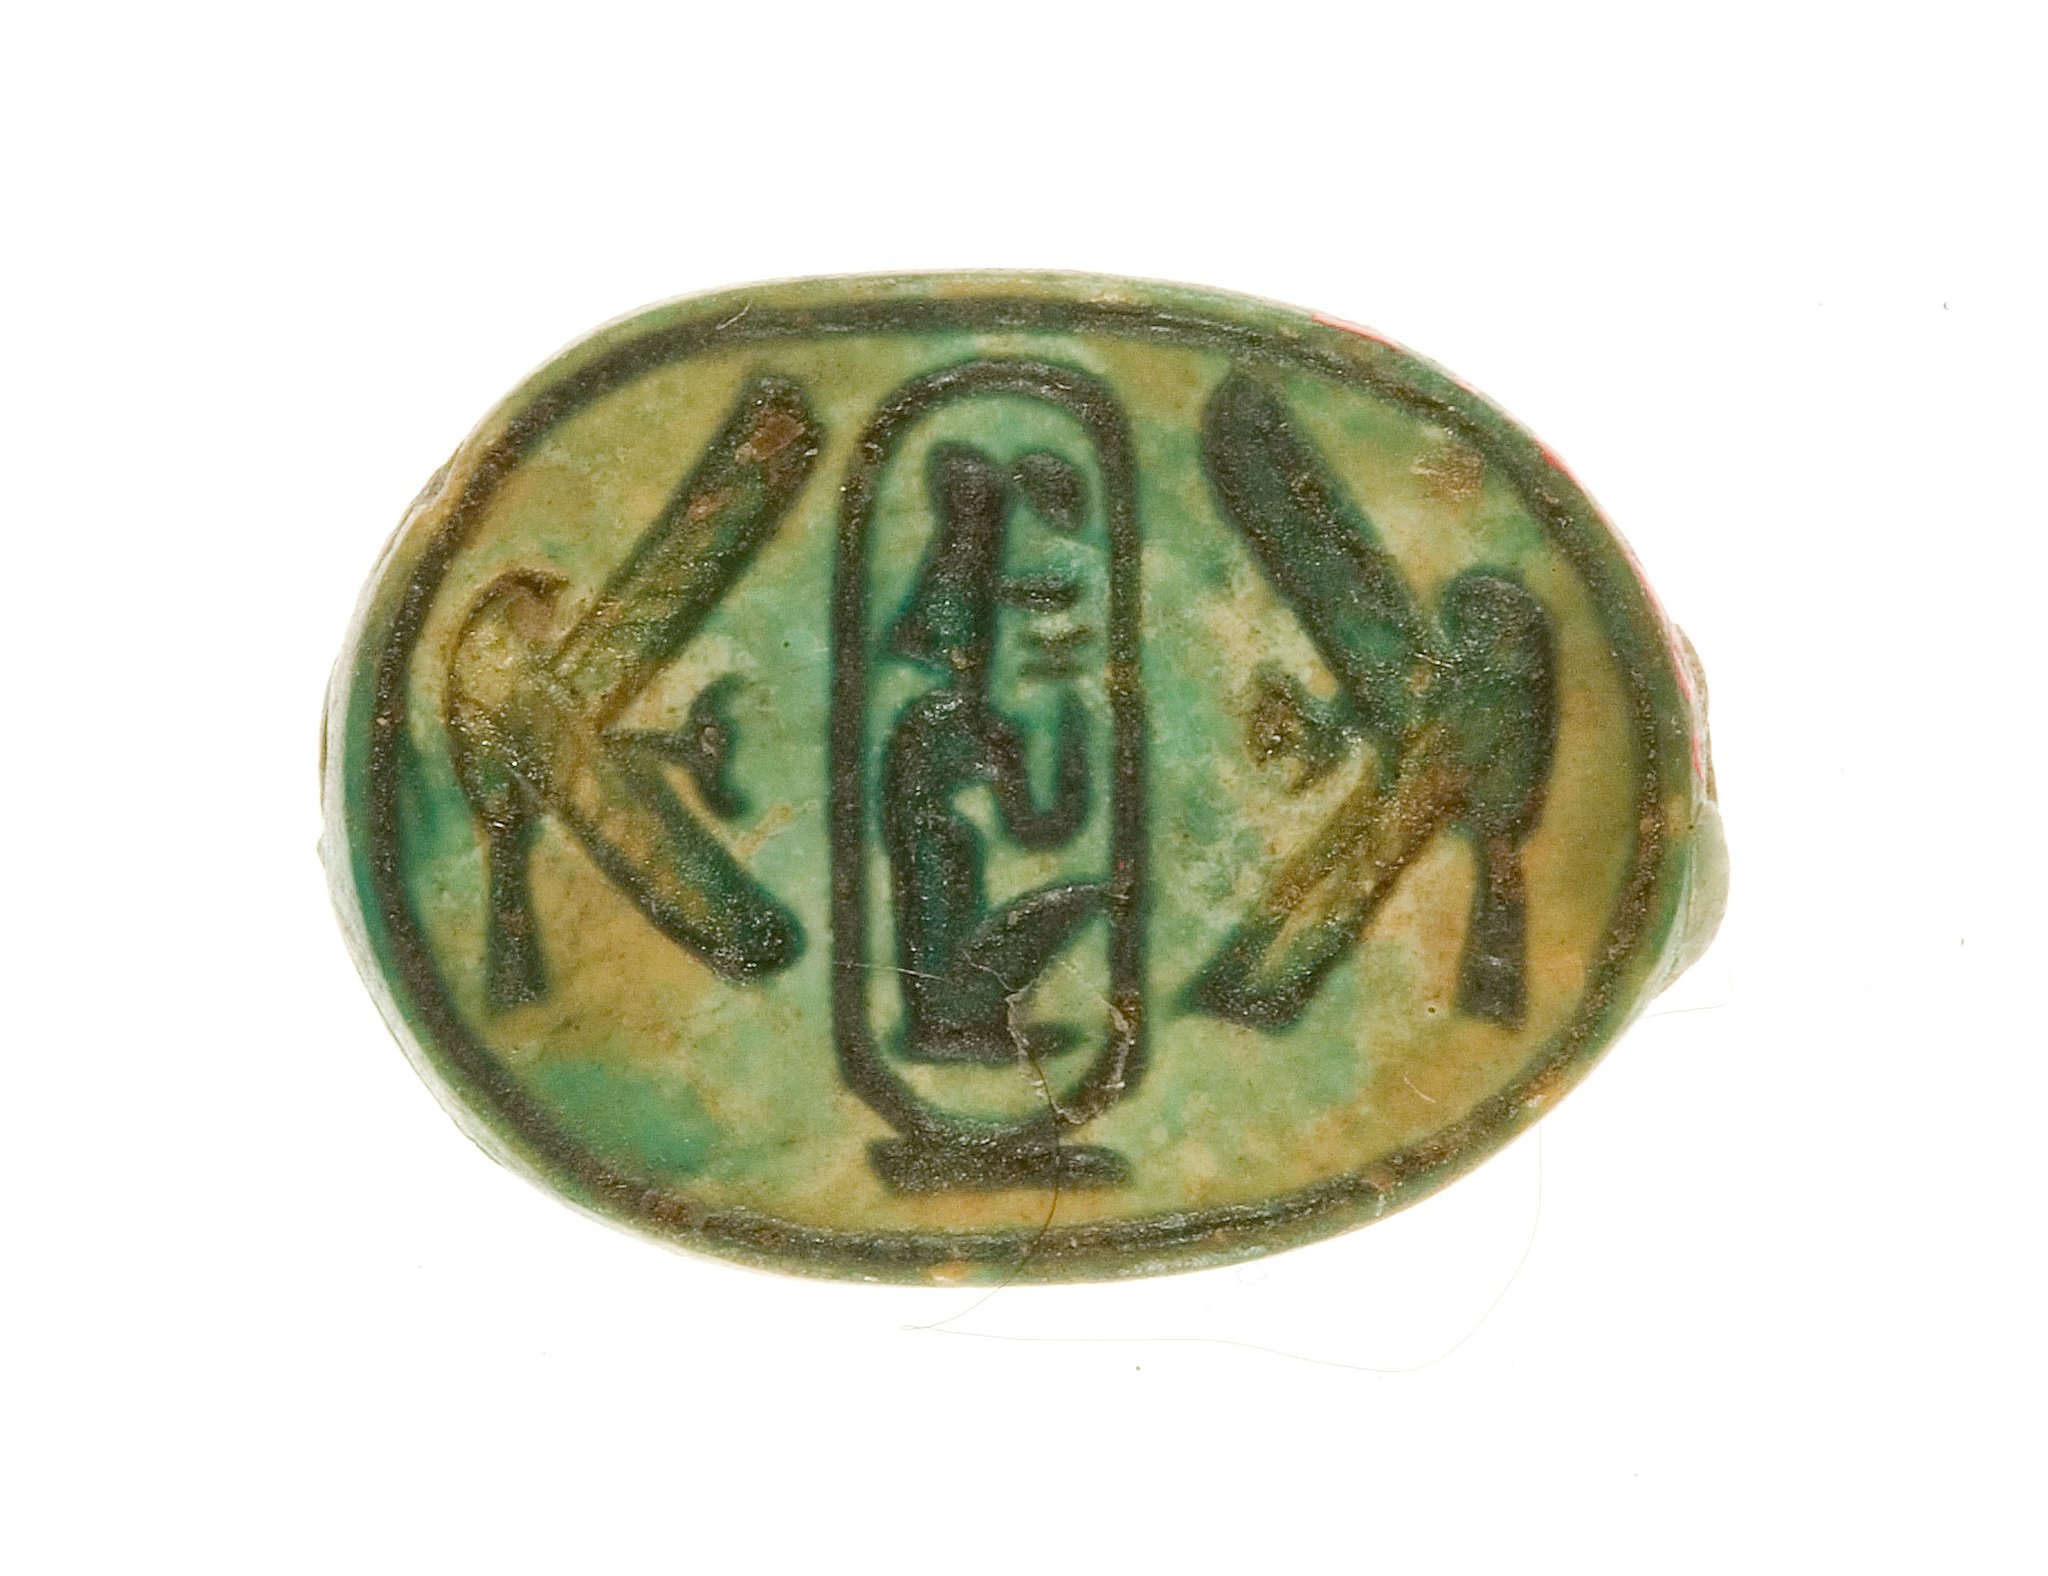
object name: scarab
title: Scarab Inscribed Lord of the Two Lands Maatkare (Hatshepsut) Flanked by Two Falcons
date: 1479-1458 BCE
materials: stone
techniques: glazing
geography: egypt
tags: falcons,hieroglyphs,scarabs